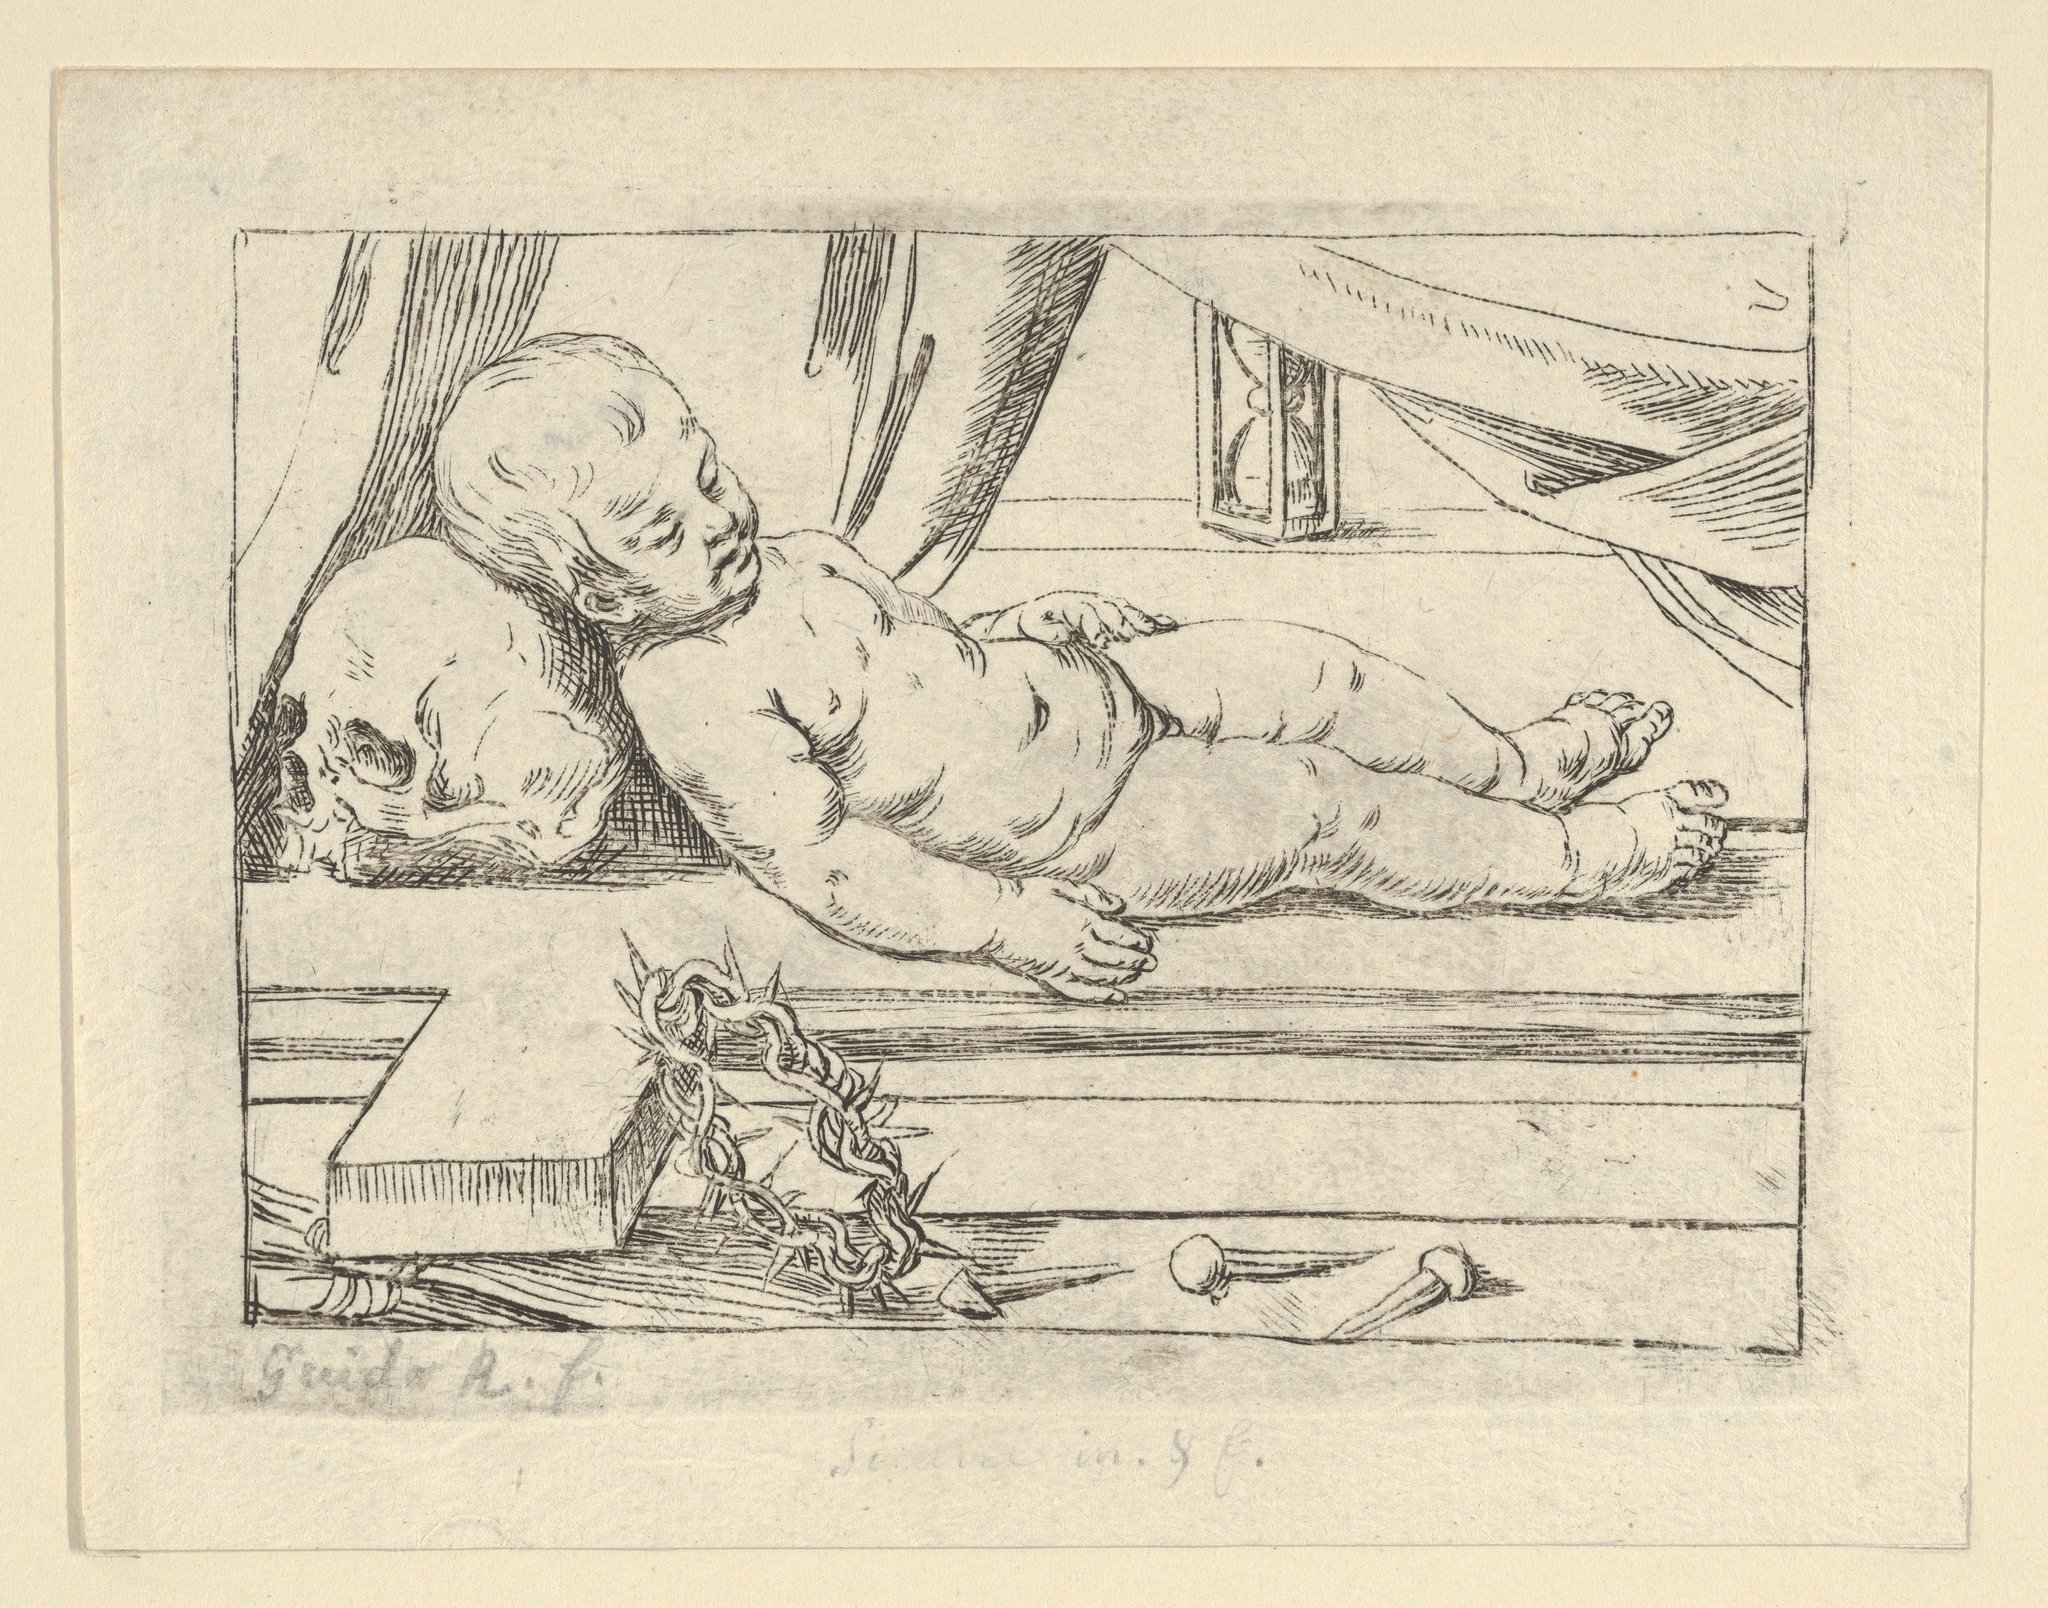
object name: print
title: The infant Christ asleep on a cross, his head resting on a skull, a crown of thorns and nails in the foreground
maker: anonymous, italian, 17th century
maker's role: artist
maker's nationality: italian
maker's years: 1600-1700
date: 1601-1700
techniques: etching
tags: skulls,sleeping,cross,jesus